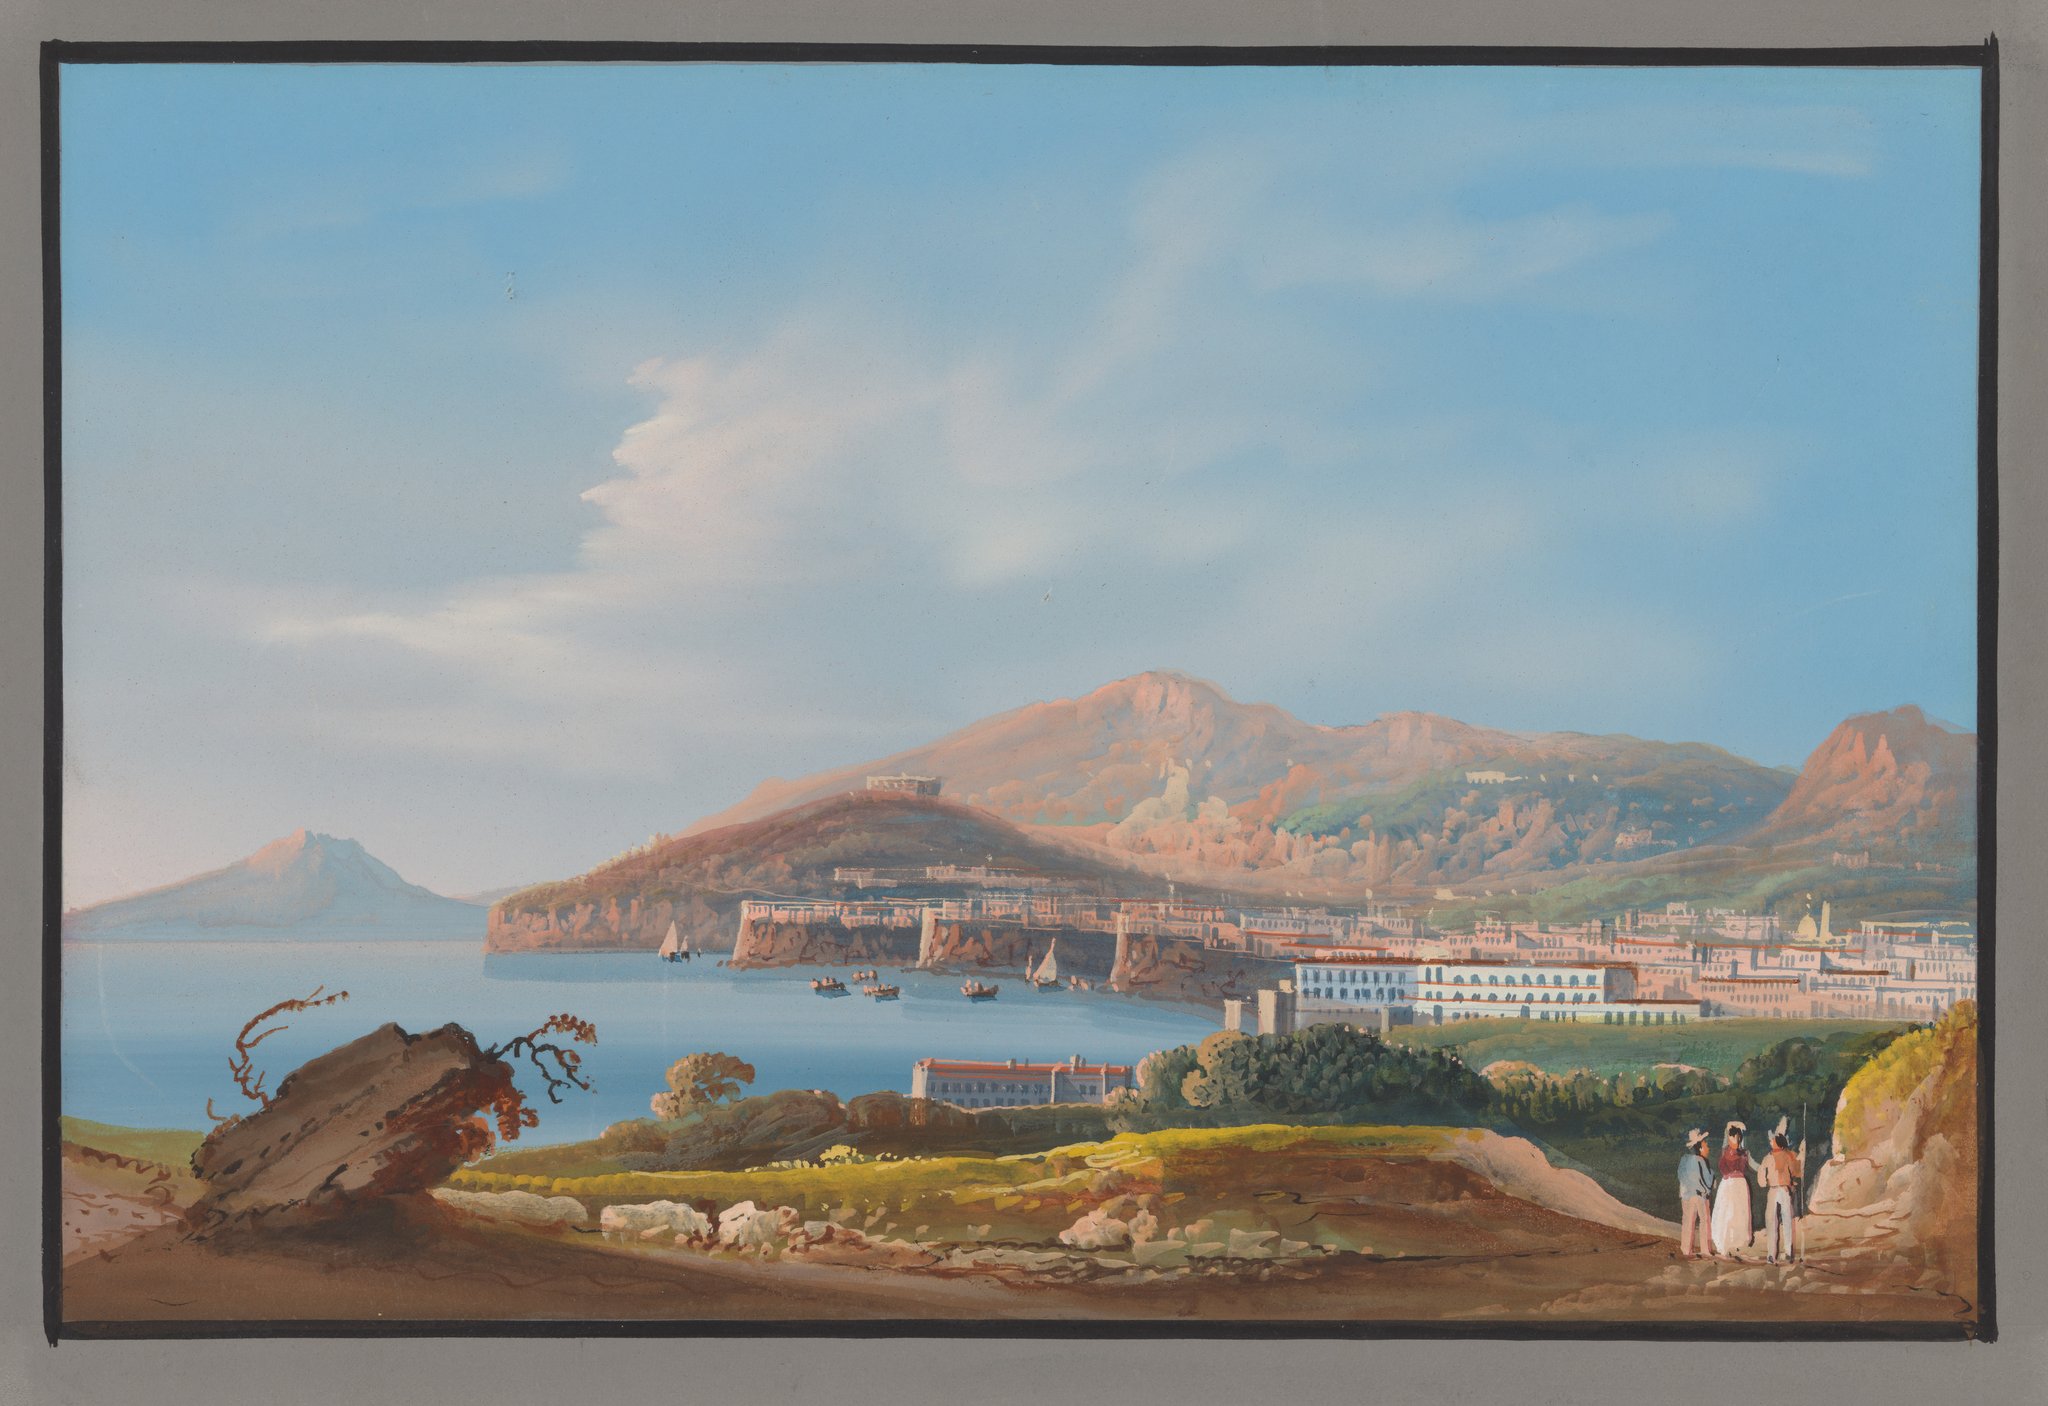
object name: drawing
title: View of Sorrento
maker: italian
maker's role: artist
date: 1810-1840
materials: gouache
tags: towns,landscapes